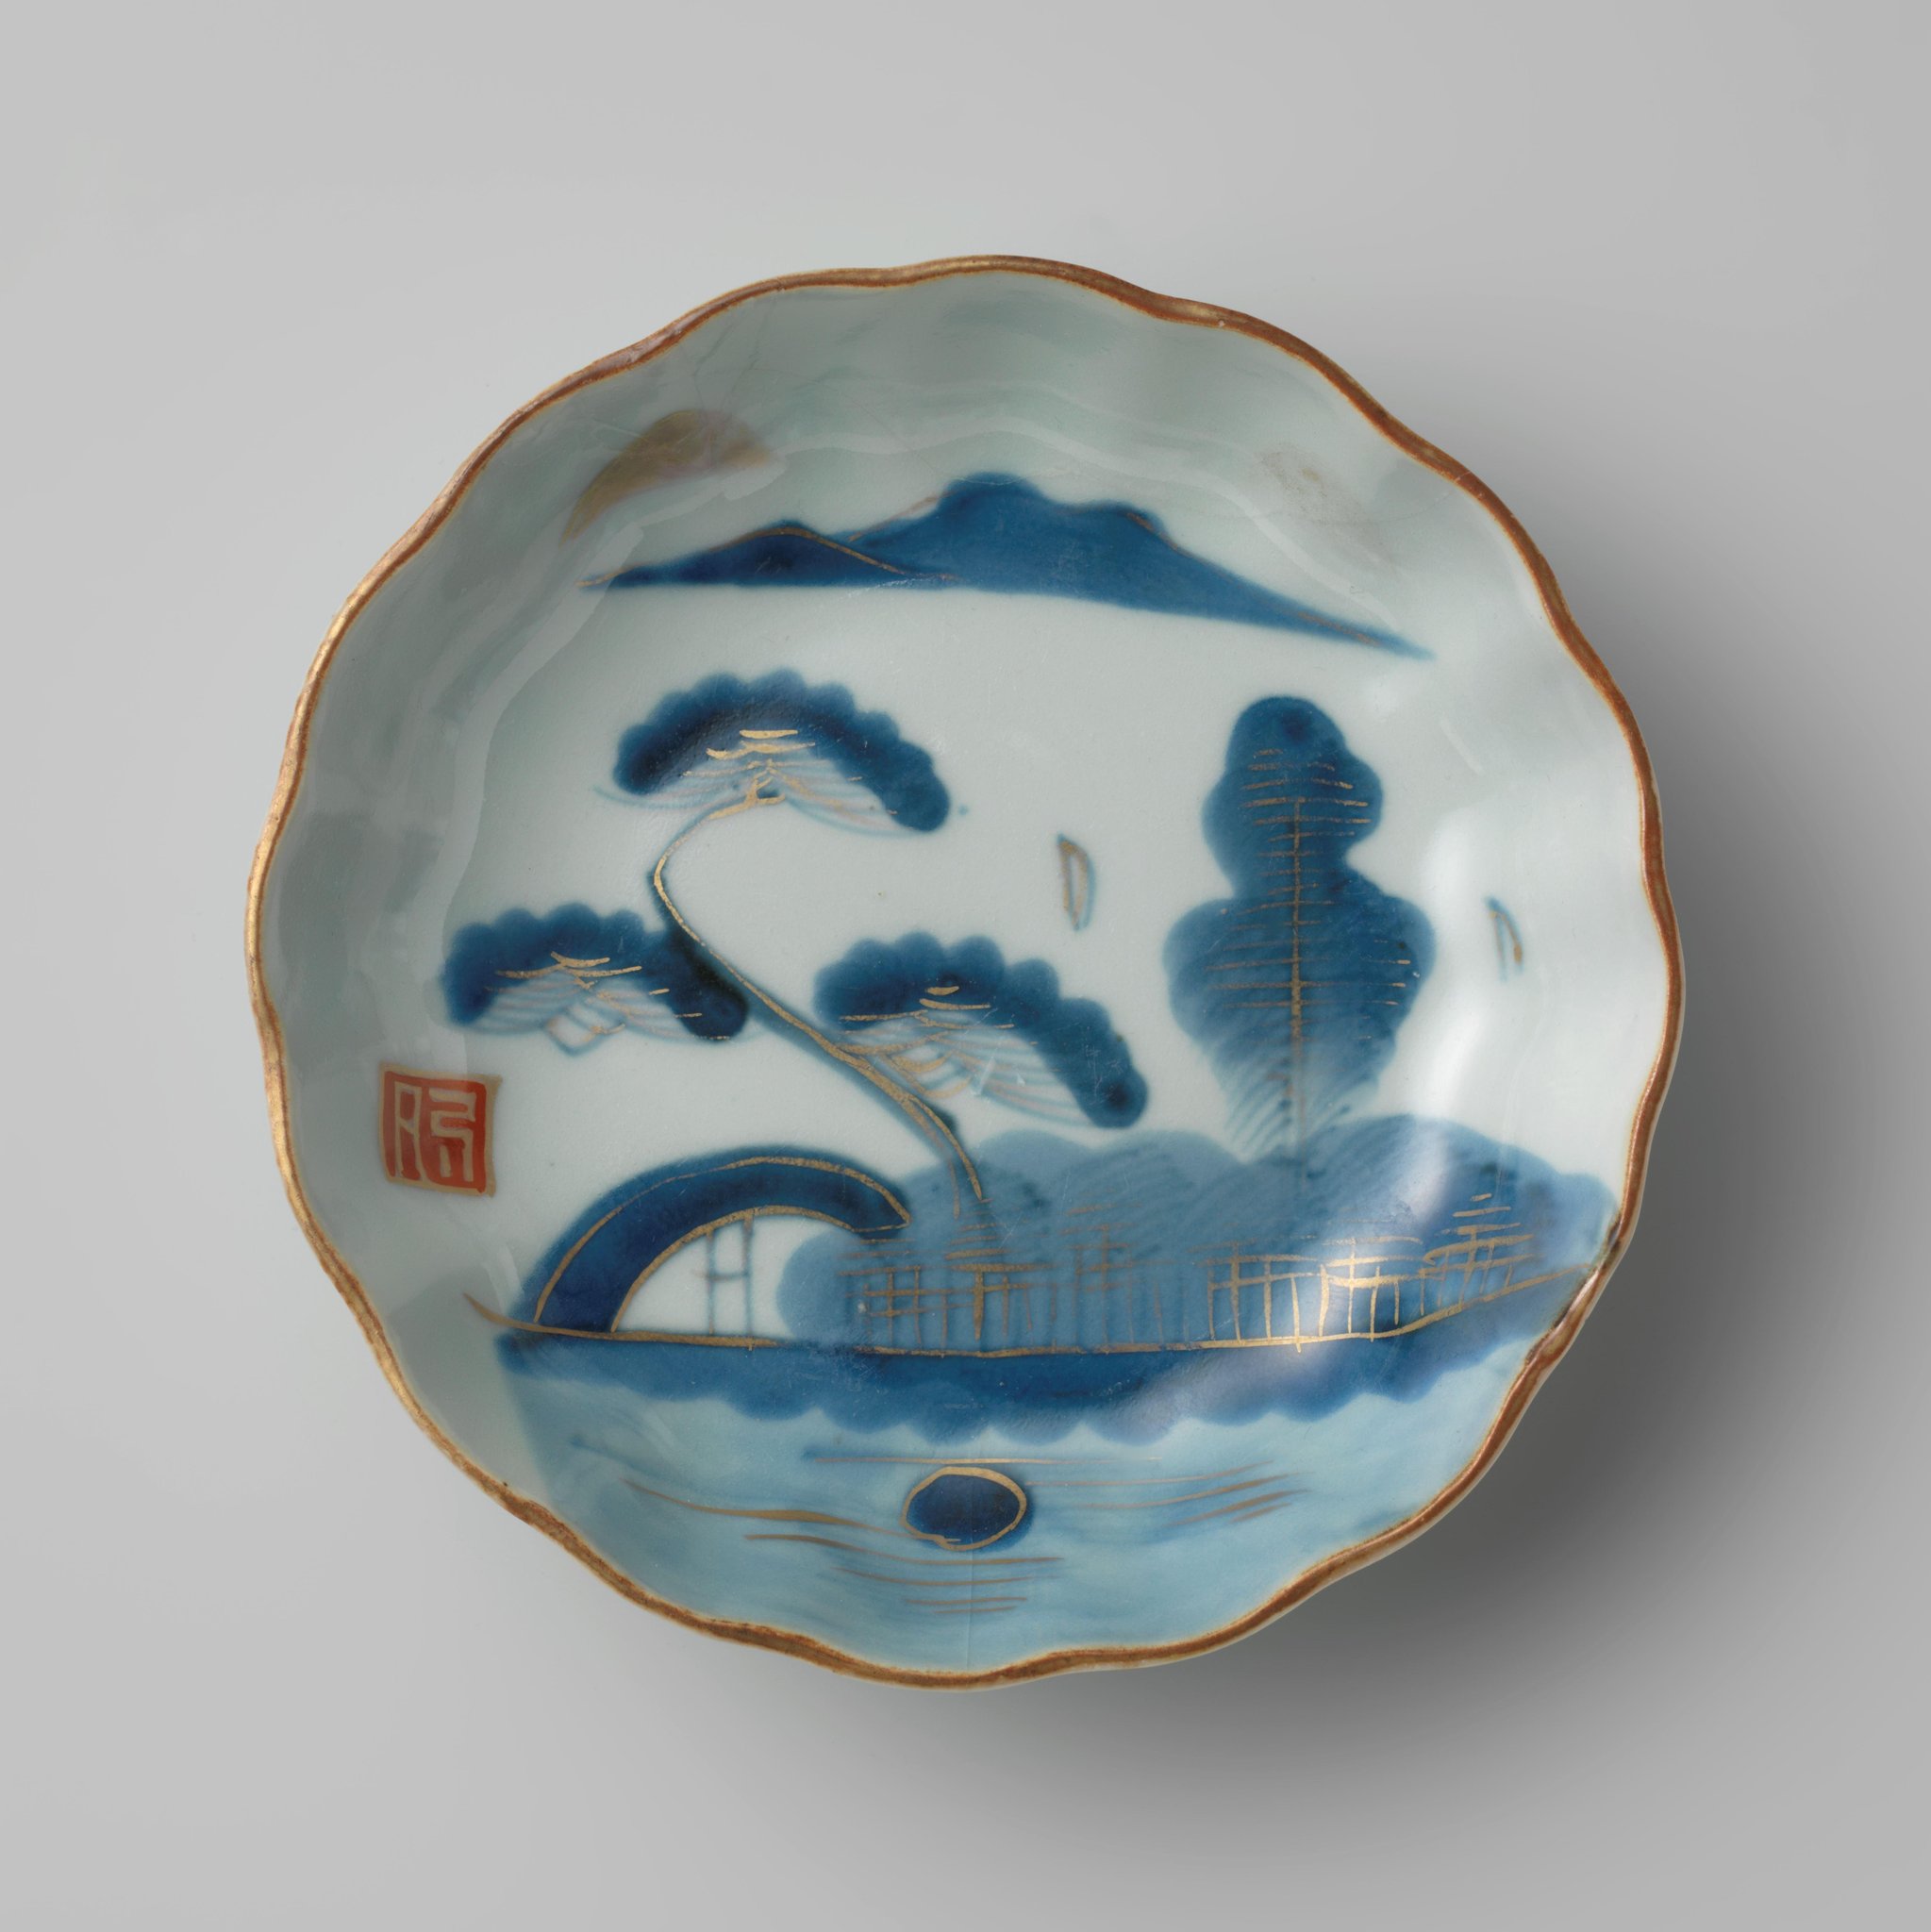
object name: dish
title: Saucer-dish with fluted sides and a water landscape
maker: Anonymous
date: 1800-1899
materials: cobalt, glaze, paint, porcelain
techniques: firing, turning, vitrification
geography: japan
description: Schaal van porselein met een geribde wand, beschilderd in onderglazuur blauw. Op de voorzijde een rivierlandschap met een brug, twee bomen en bergen. Op de wand een zegel in rood en goud email. De wand is gebroken geweest. Blauw-wit.